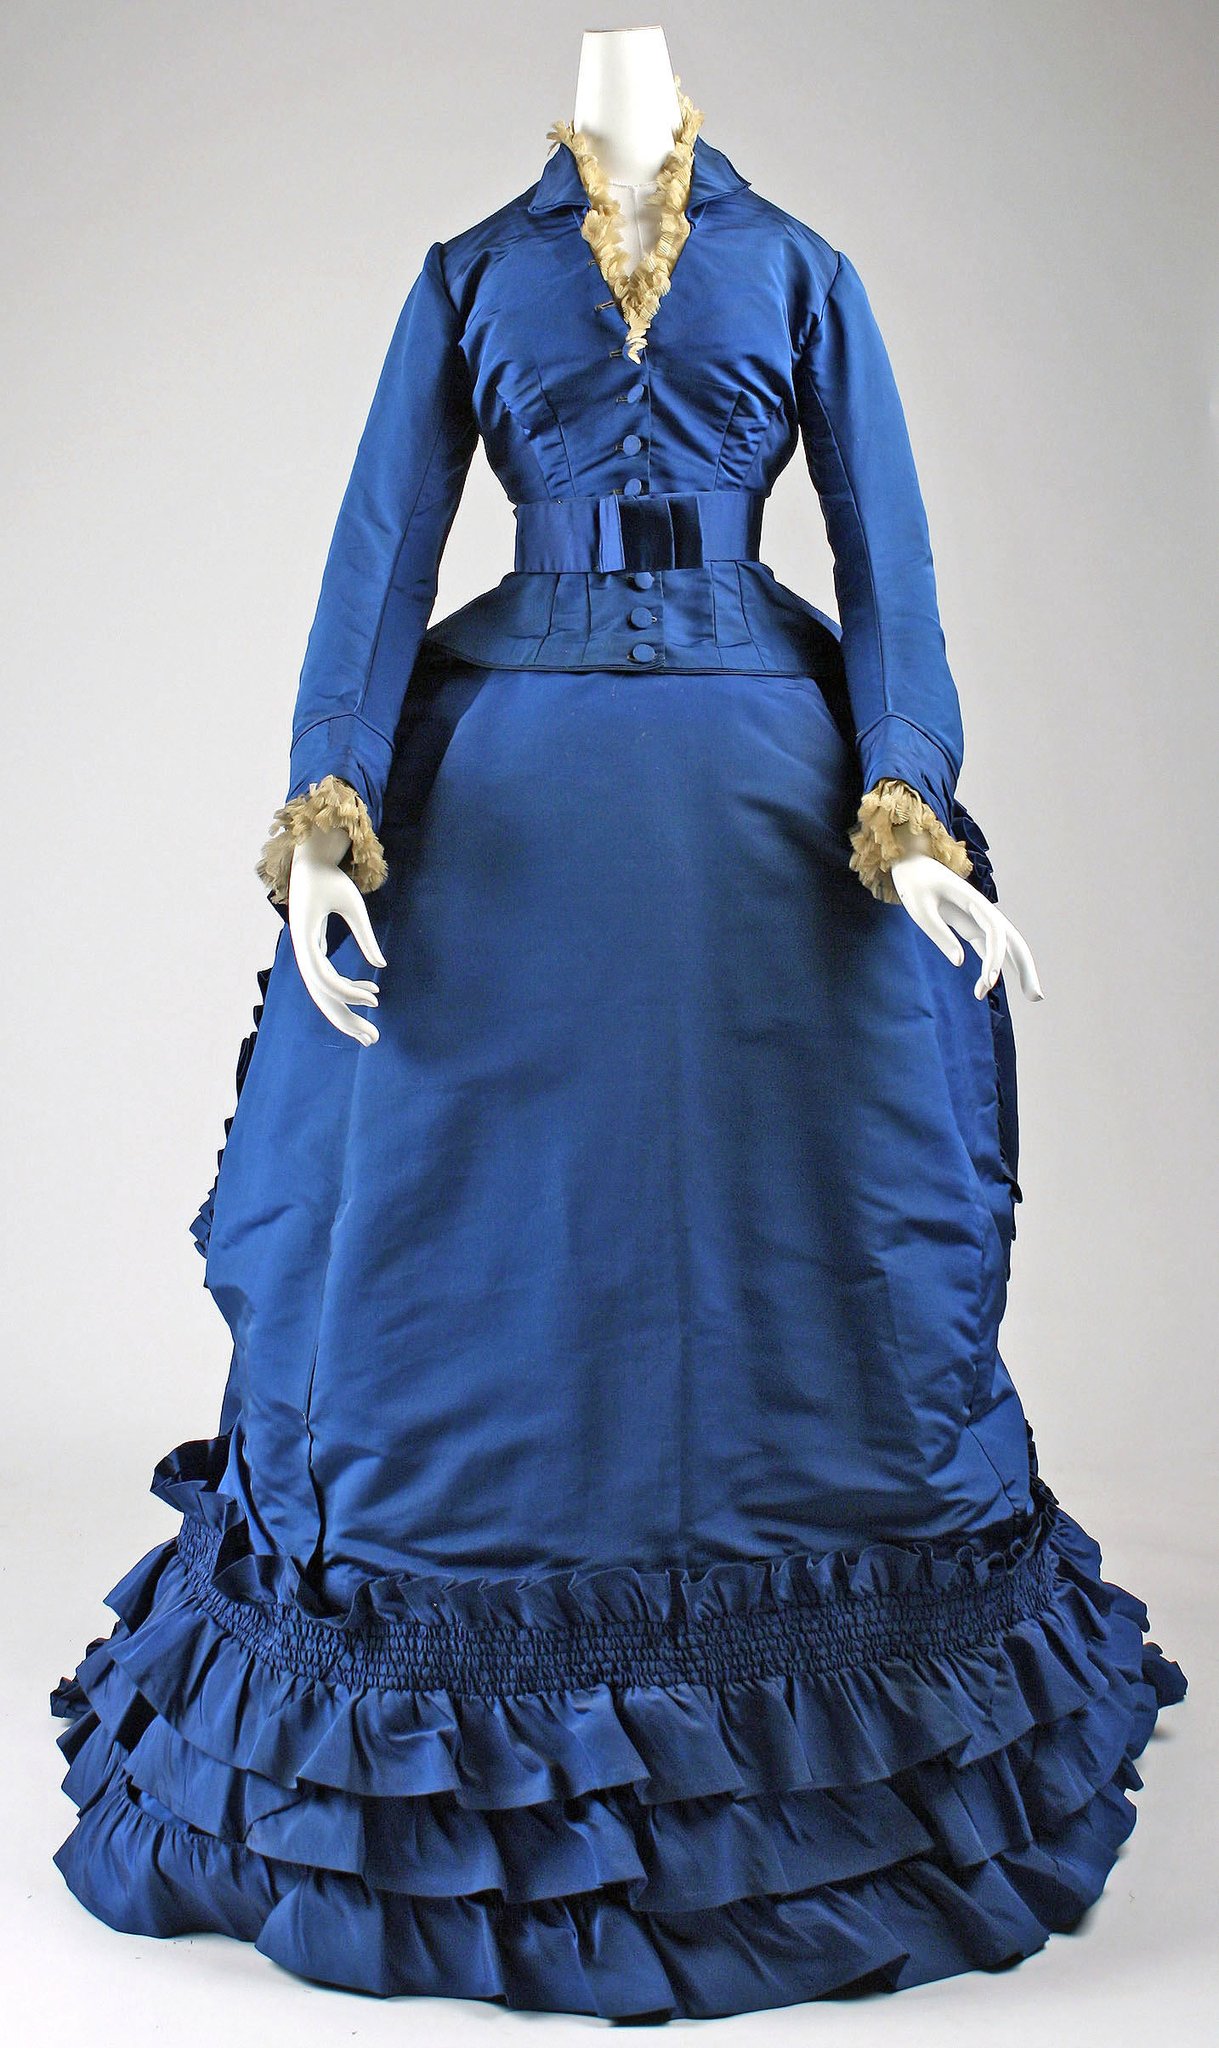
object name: dress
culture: french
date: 1870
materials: silk